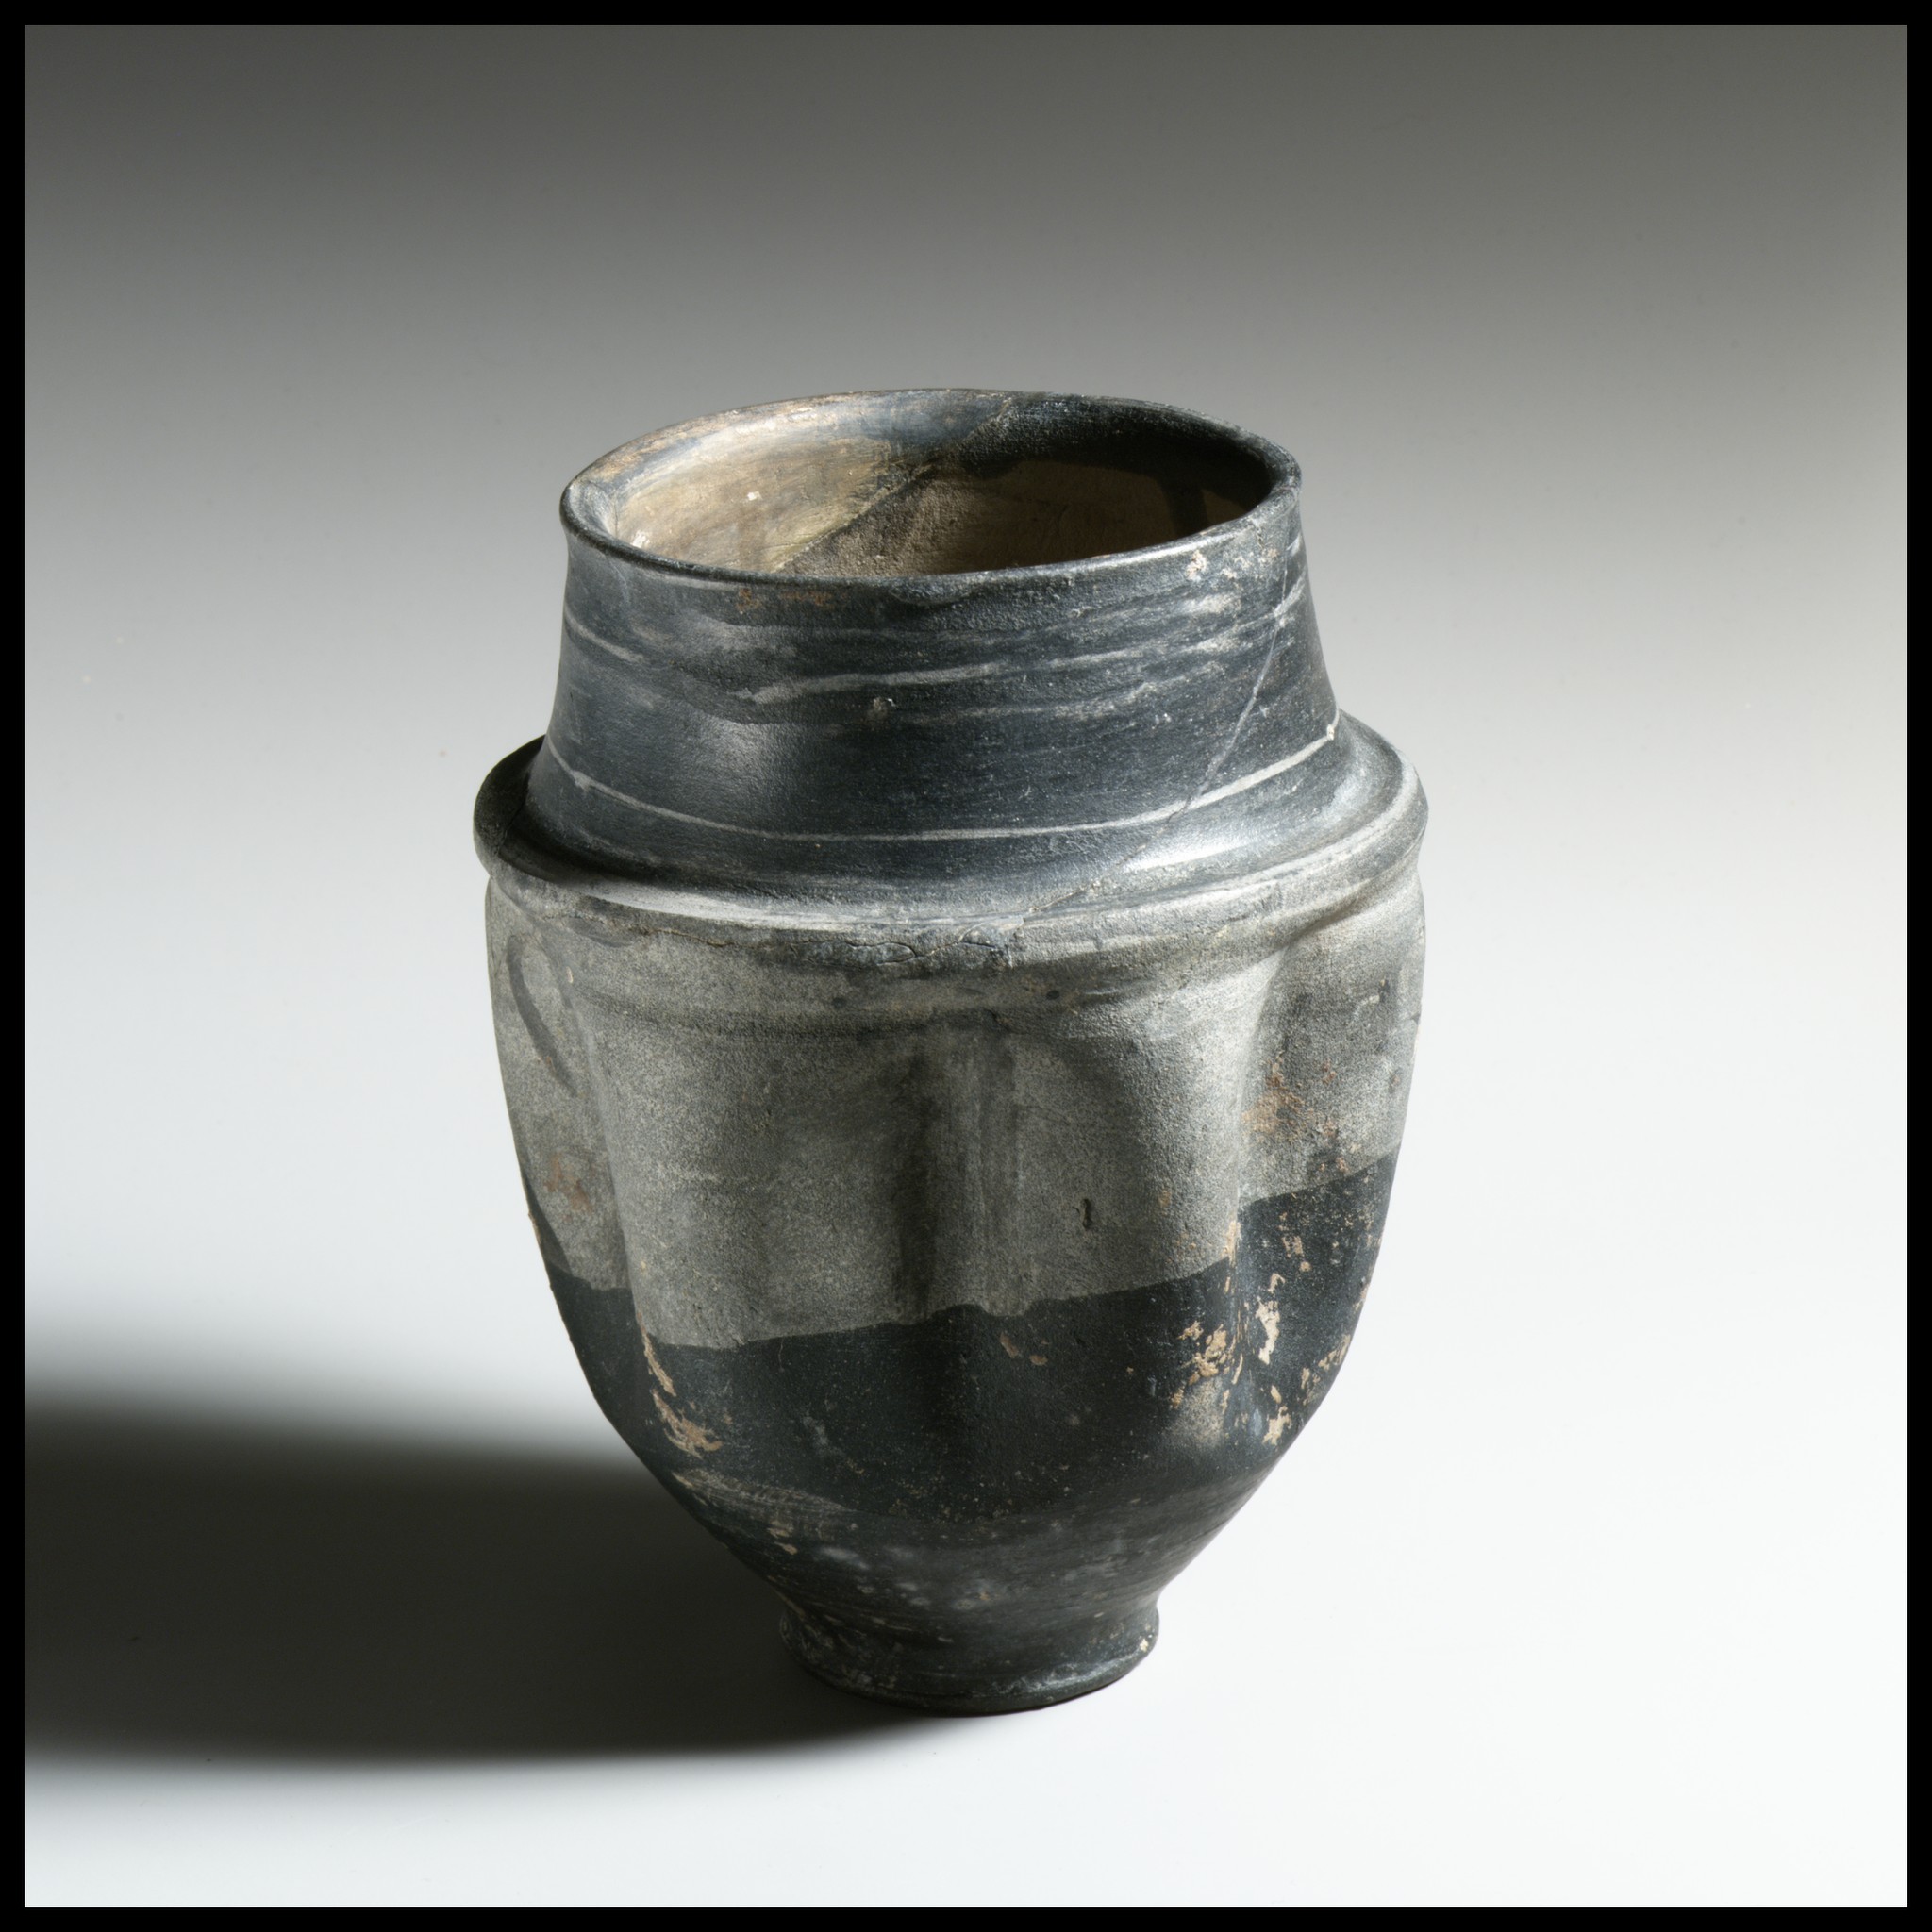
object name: beaker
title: Terracotta indented beaker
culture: roman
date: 134-233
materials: terracotta